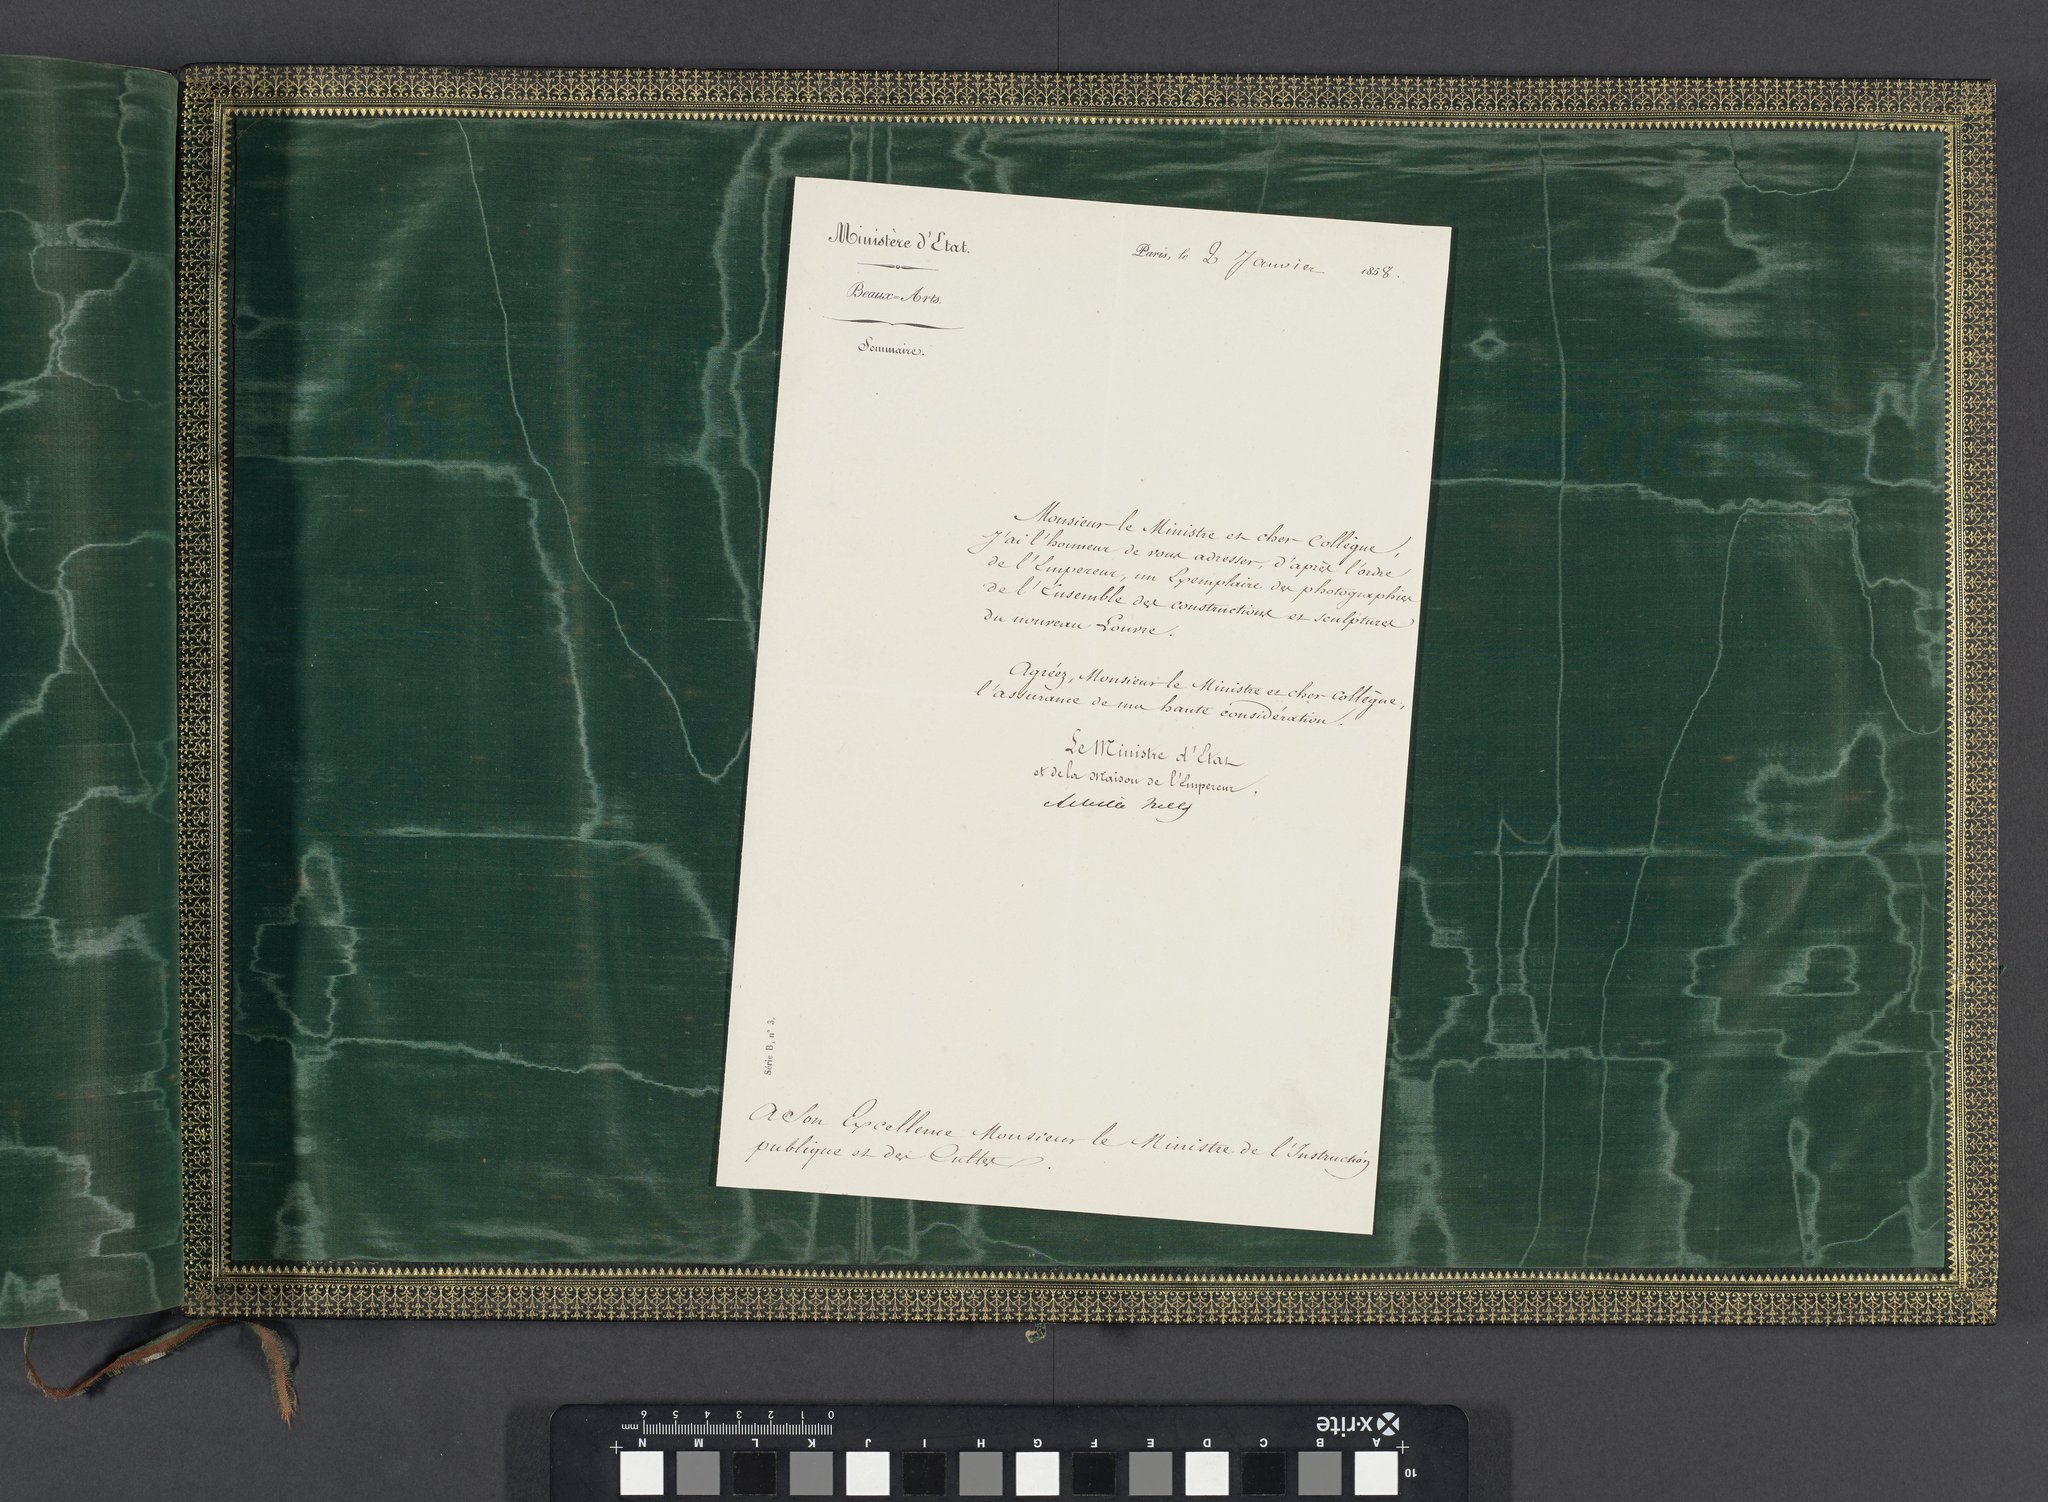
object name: letter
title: Aanbiedingsbrief behorend bij fotoalbums Réunion des Tuileries au Louvre 1852-1857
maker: achille fould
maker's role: politician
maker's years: 1800-1867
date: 1858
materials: paper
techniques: writing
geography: paris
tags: piece of sculpture, reproduction of a piece of sculpture, permanent exhibition, museum, letter, envelope, paris, tuileries palace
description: Handgeschreven brief gedateerd 2 januari 1858 waarin de Franse minister Achille Fould de vier delen van het fotoalbum aanbiedt aan zijn collega-minister Gustave Rouland, namens keizer Napoleon III. Onderdeel van Réunion des Tuileries au Louvre 1852-1857, album 1.